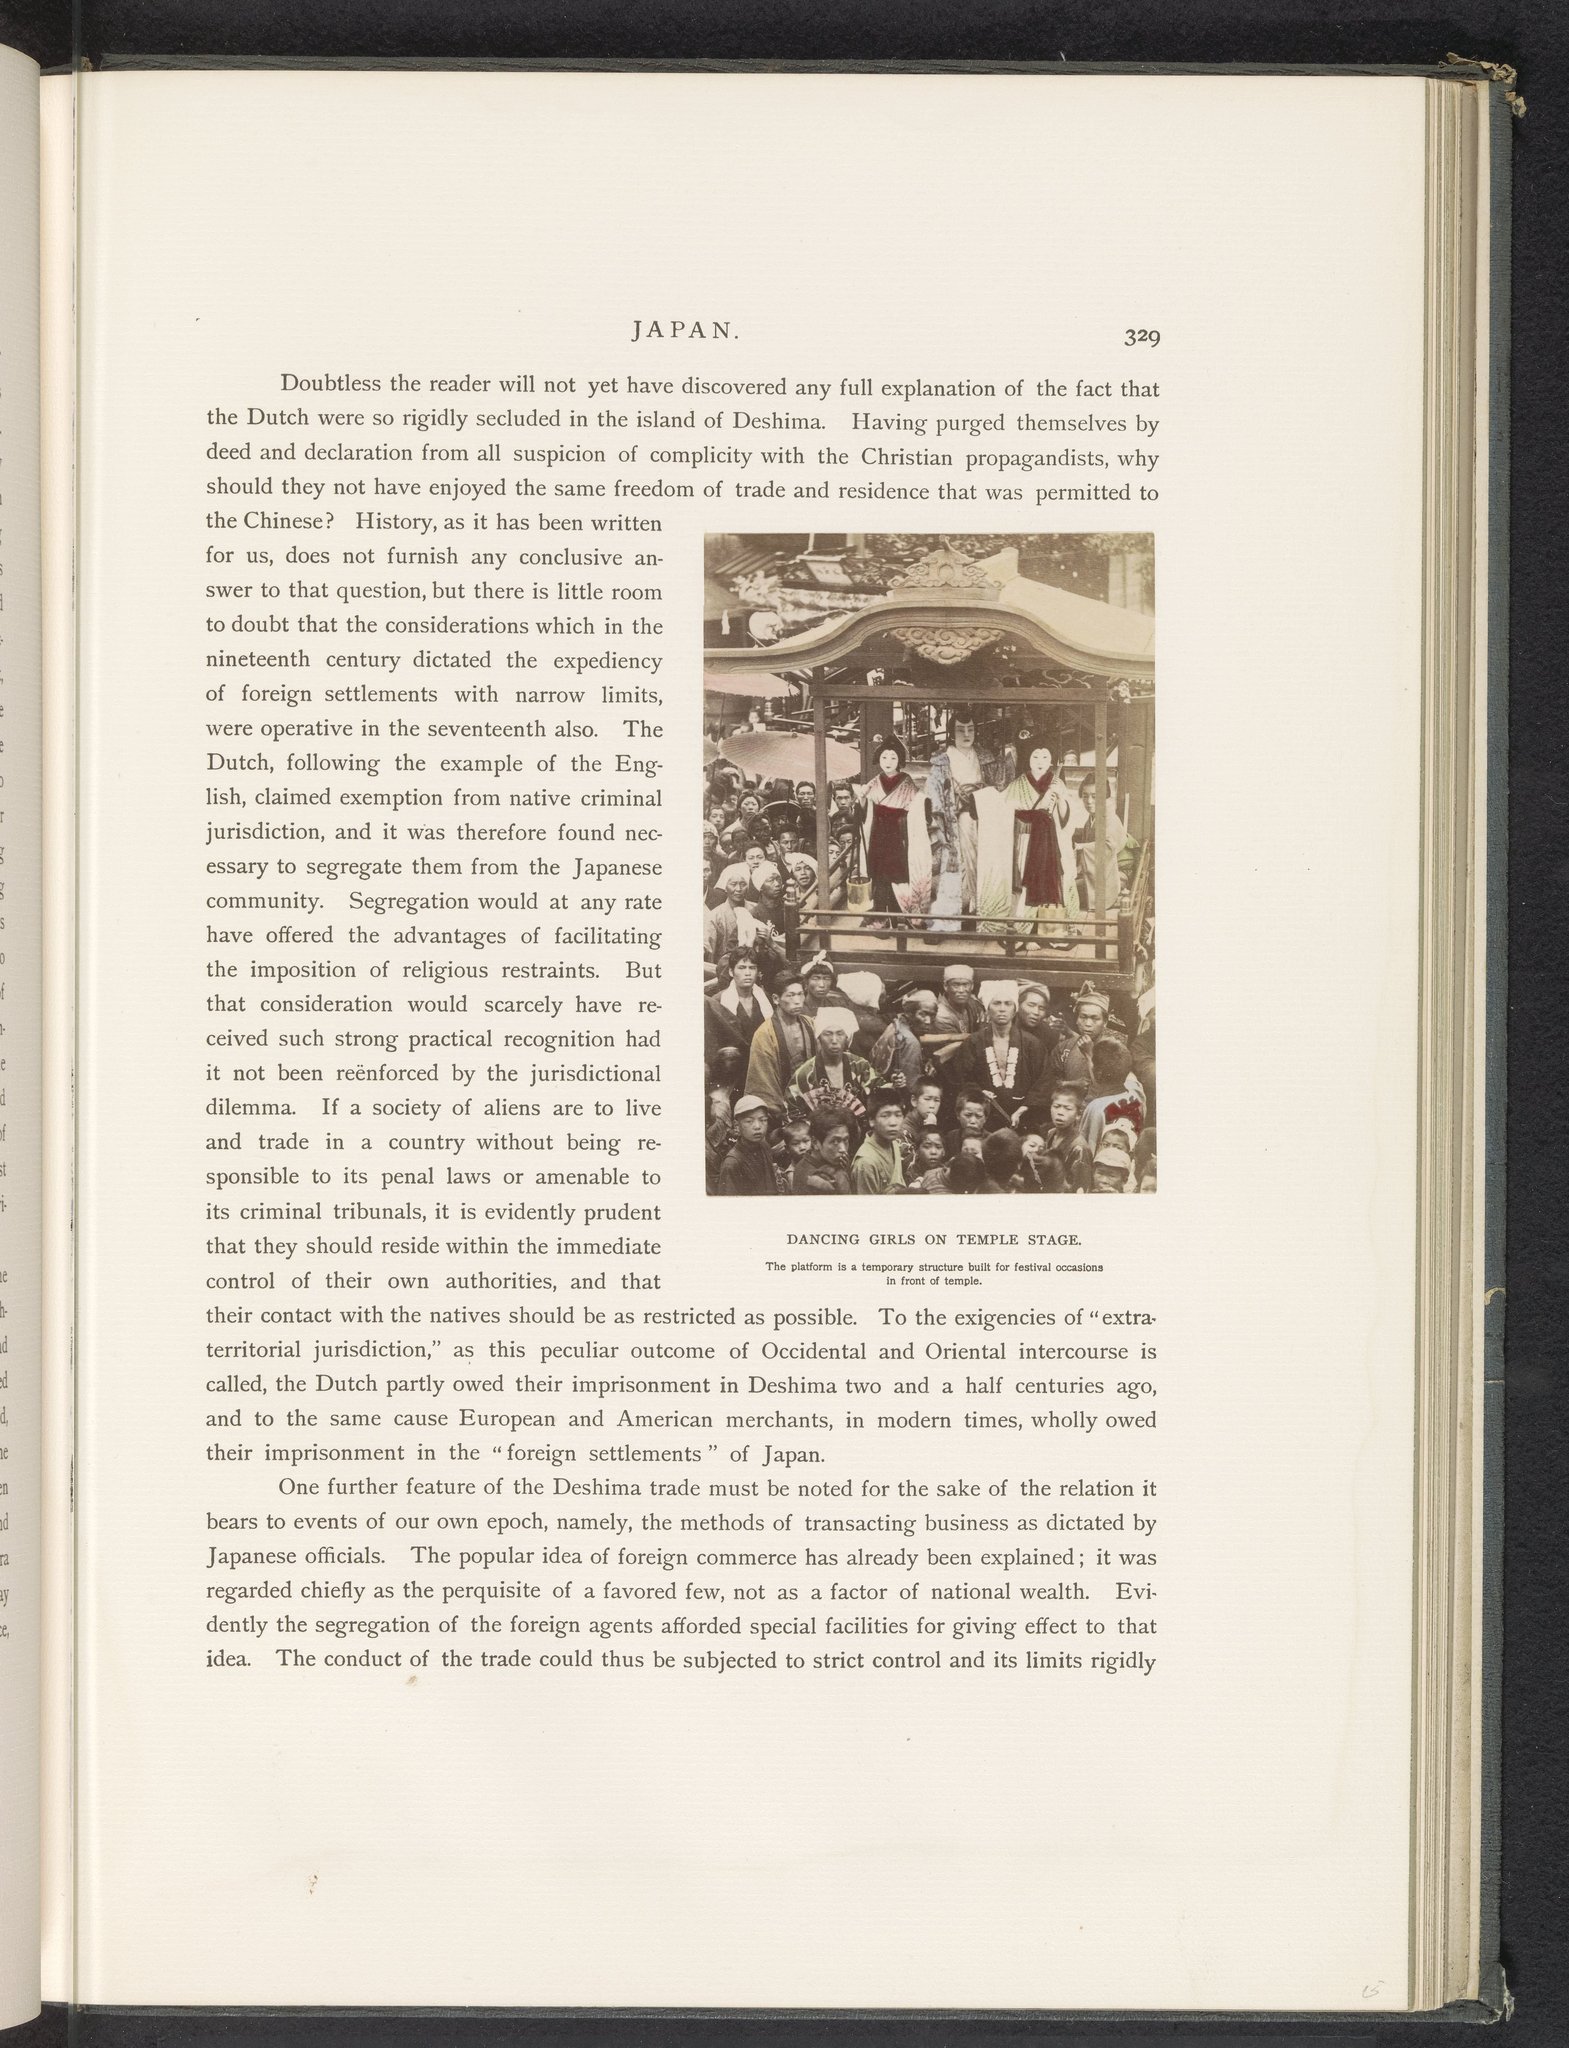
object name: photograph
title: Dancing girls on temple stage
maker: Anonymous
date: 1887-1897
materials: photographic support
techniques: albumen print, hand coloring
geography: japan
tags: ballet group; dancers on the stage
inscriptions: inscription: ‘The platform is a temporary structure built for festival occasions in front of temple.’